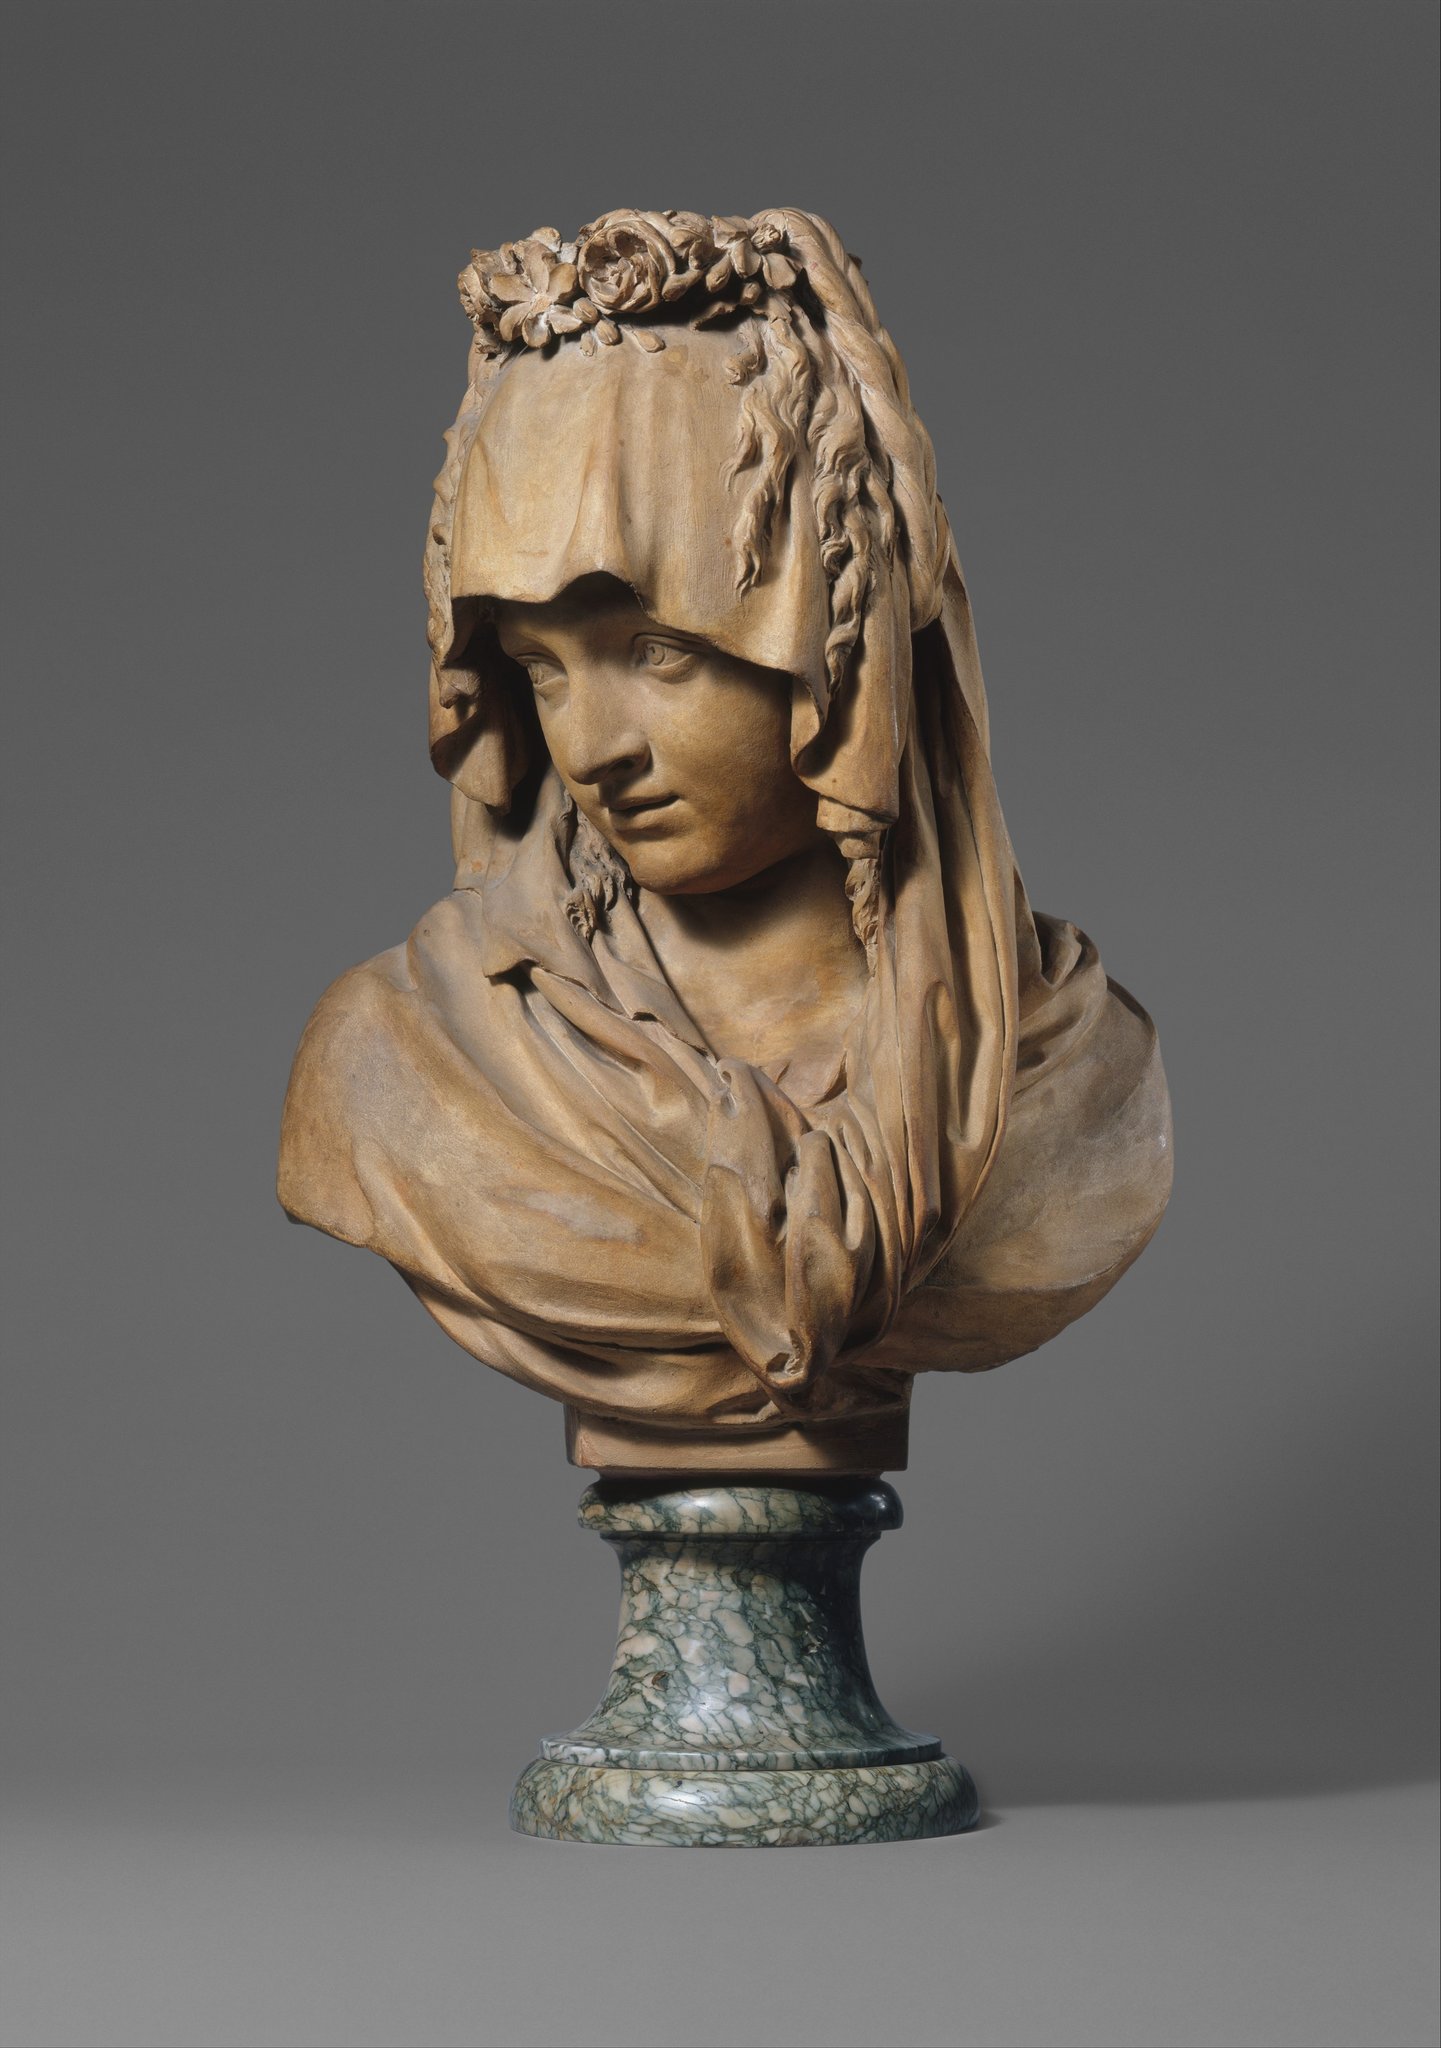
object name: bust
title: Bust of a Girl Veiled and Crowned with Flowers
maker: pierre julien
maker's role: artist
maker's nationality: french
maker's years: 1731-1804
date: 1779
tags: girls